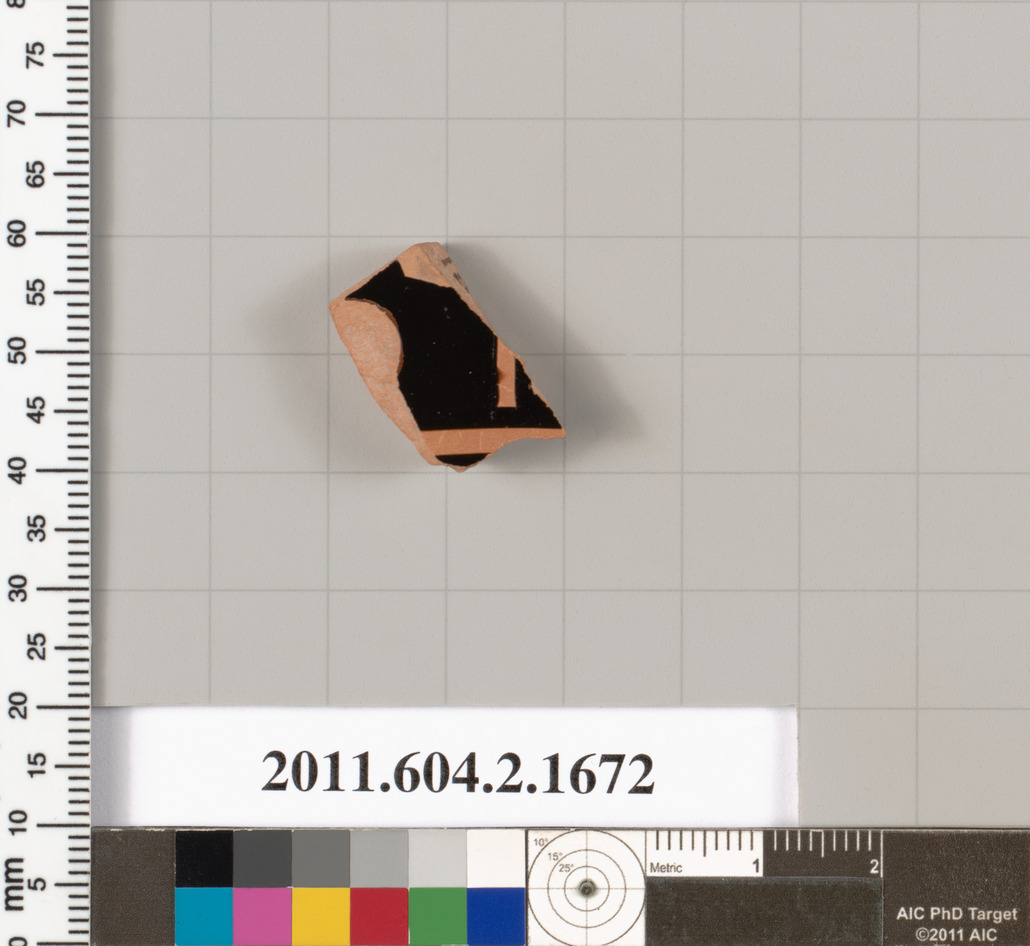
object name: skyphos fragment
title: Terracotta fragment of a skyphos (deep drinking cup)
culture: greek, attic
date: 450-401 BCE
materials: terracotta